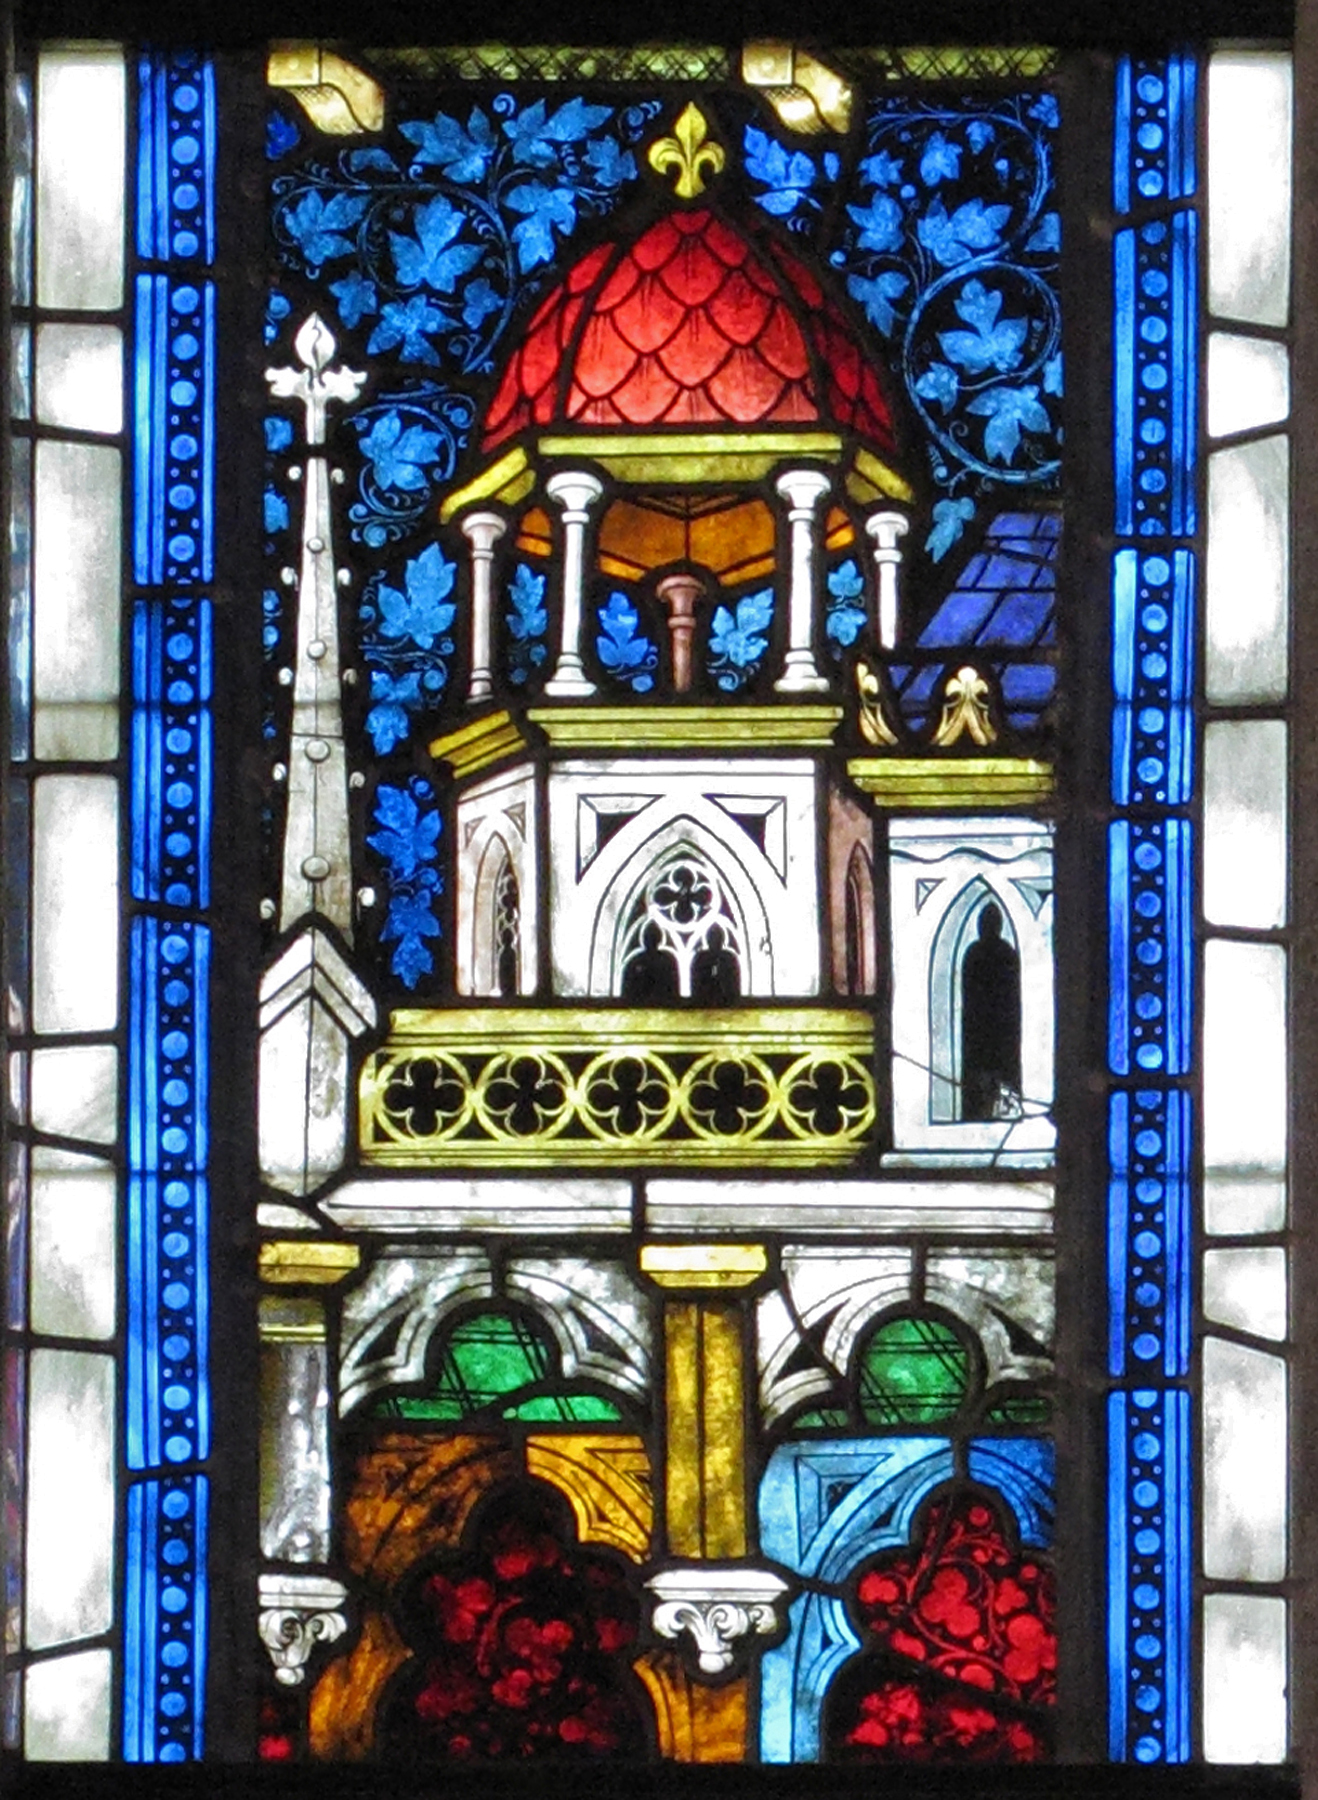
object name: panel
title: Architectural canopy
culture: austrian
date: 1390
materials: glass, metal, paint, pigment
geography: austria